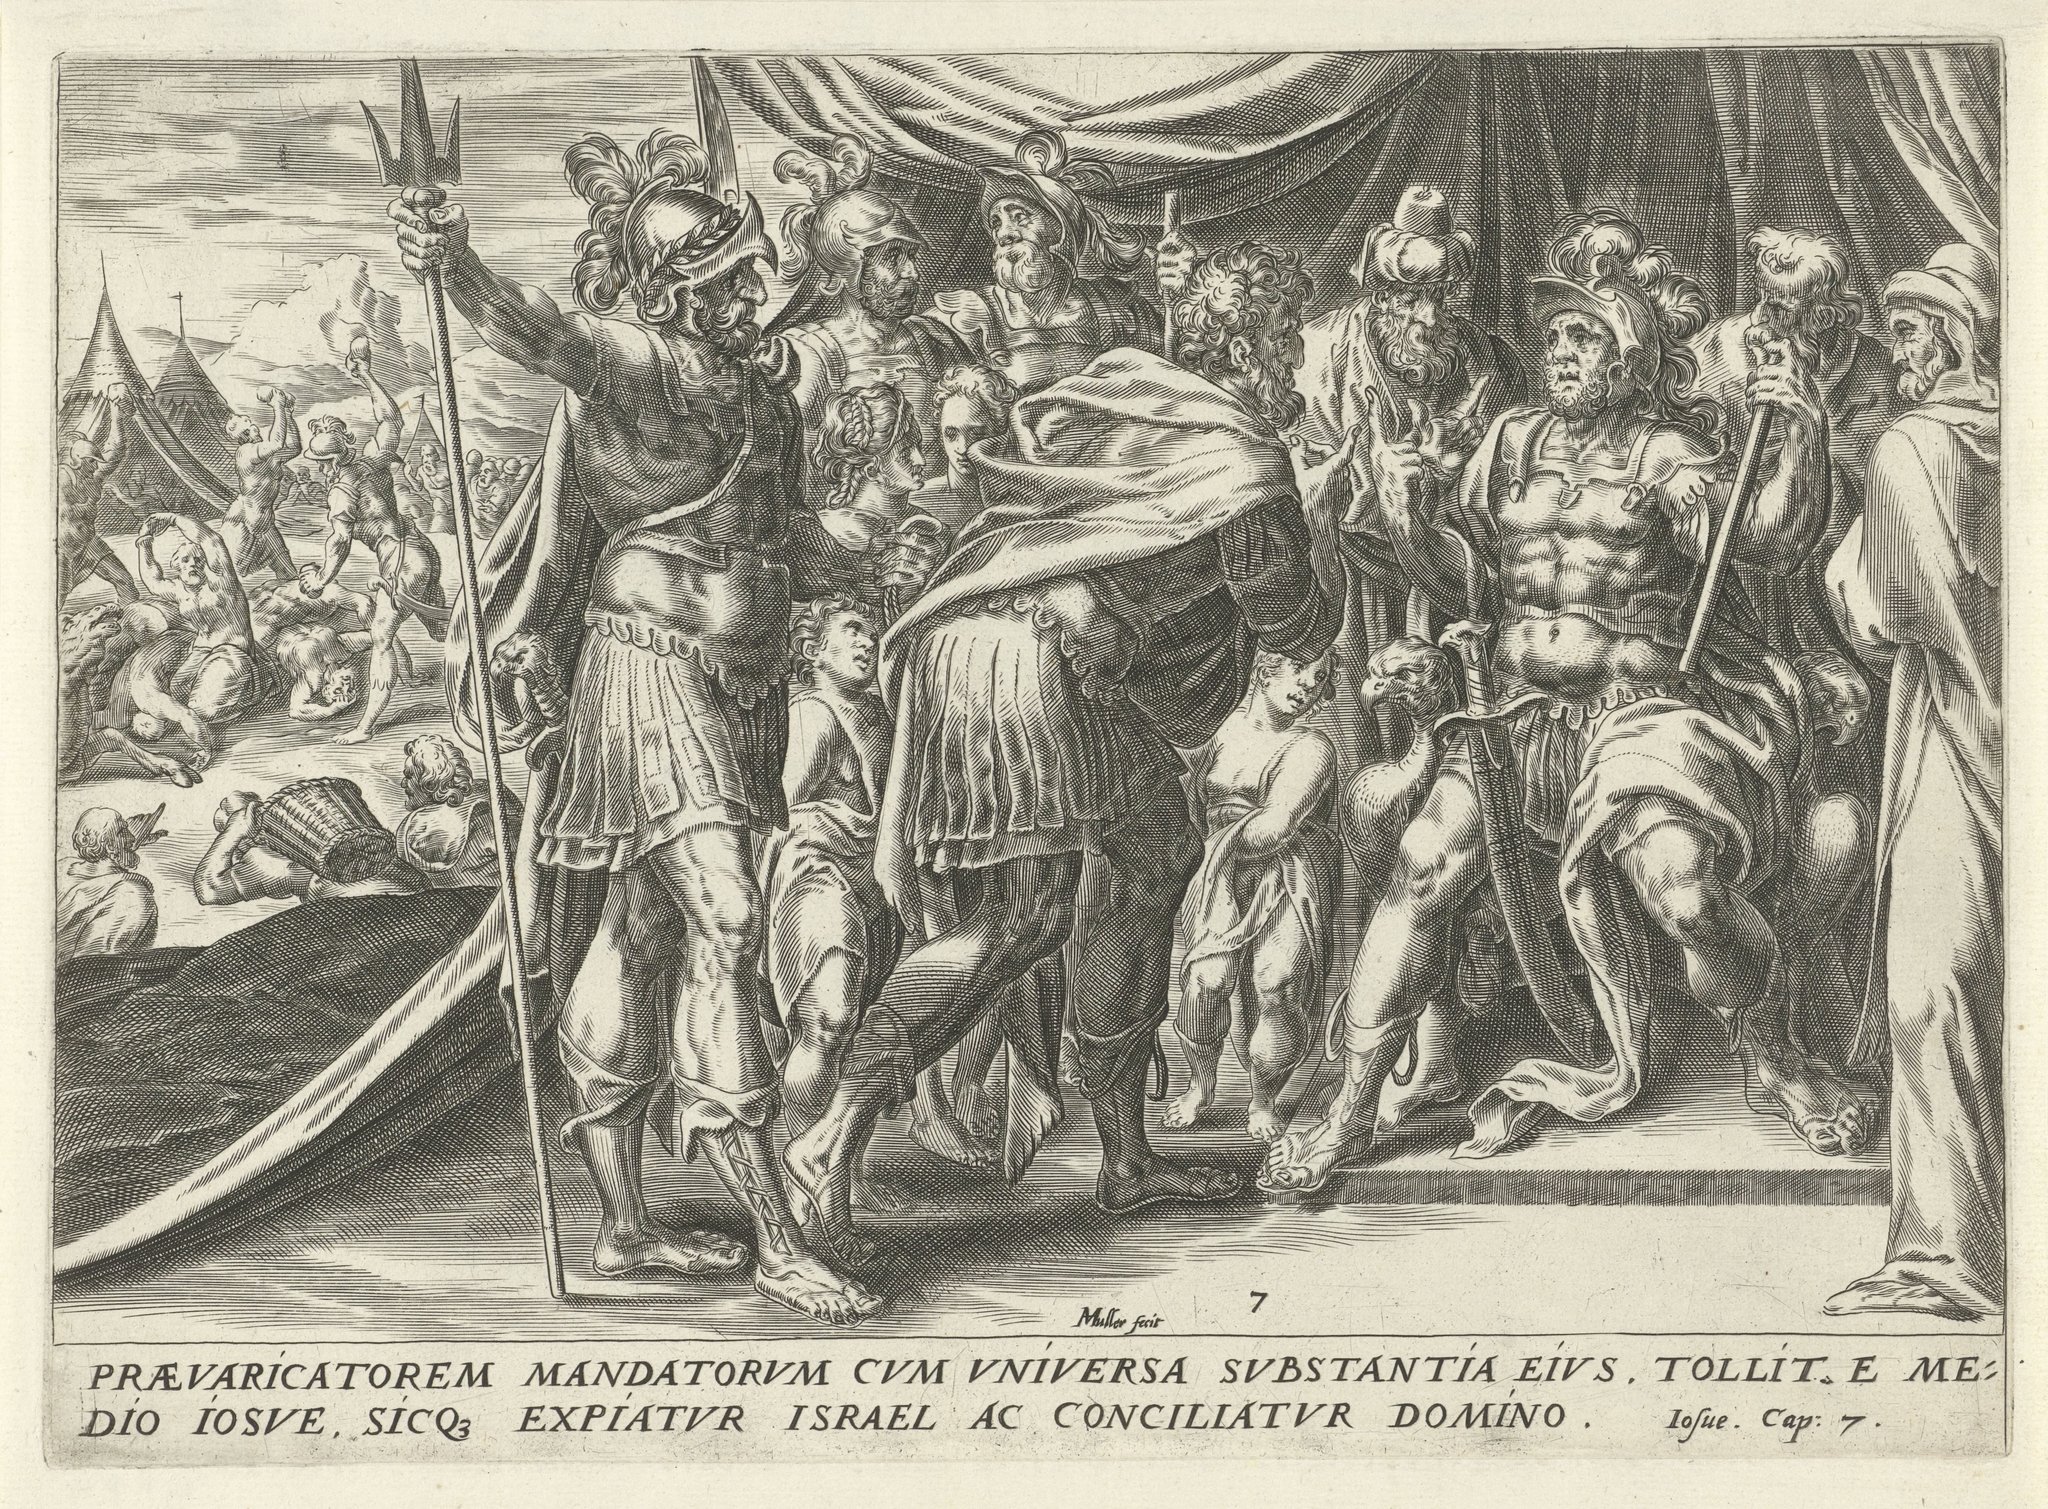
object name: print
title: De geschiedenis van Jozua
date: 1567-1570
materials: paper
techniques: engraving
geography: antwerp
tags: achan and his family are stoned and burned (aftermath of the fall of jericho), achan confesses to have taken from the spoils a garment and some silver and gold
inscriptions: collector's mark: Lugt 2228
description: Achan wordt voorgeleid aan Jozua, omdat hij oorlogsbuit had gestolen. Op de achtergrond worden Achan en zijn familie gestenigd. Onderaan in de marge een verwijzing naar de Bijbeltekst in het Latijn.